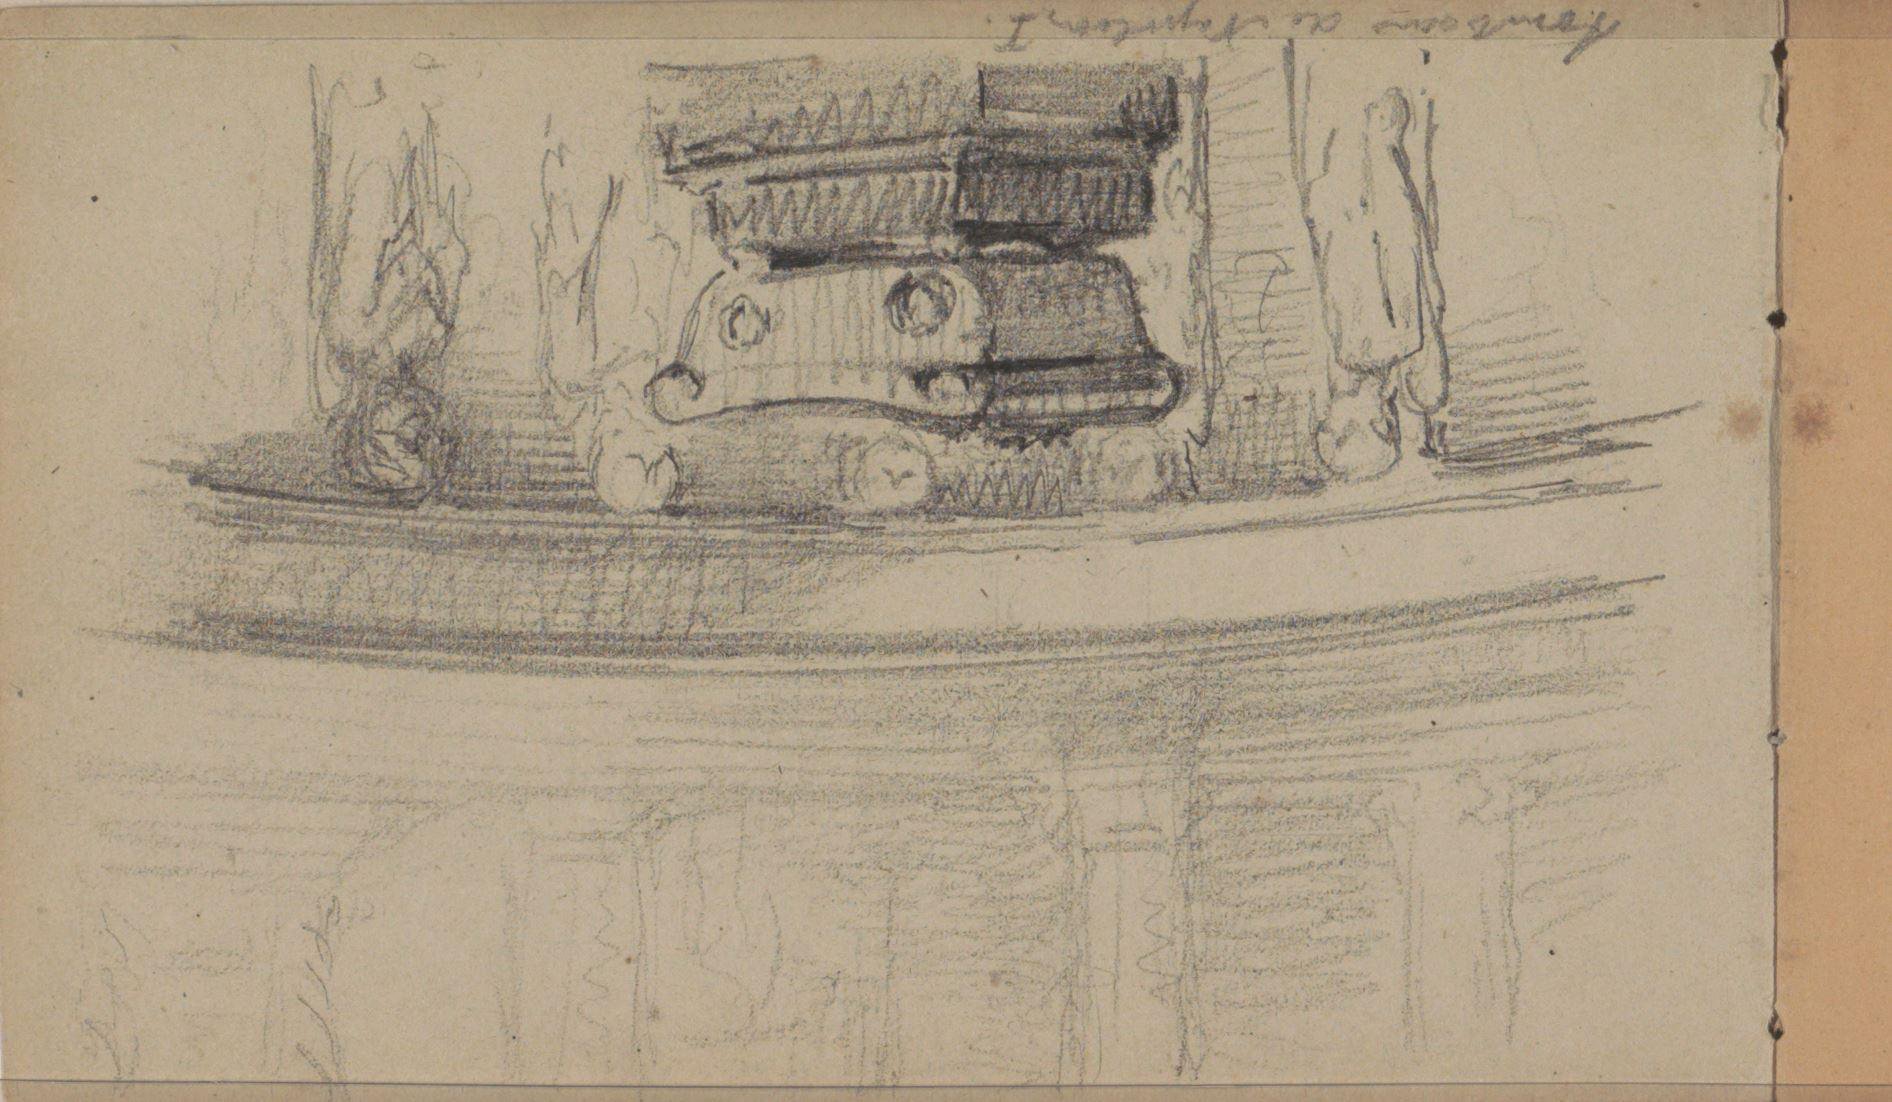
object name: sketchbook leaf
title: Tombe van Napoleon I Bonaparte in de Dôme des Invalides te Parijs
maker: maria vos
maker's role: draughtsman, painter, print maker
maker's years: 1824-1906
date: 1811-1867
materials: paper, pencil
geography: paris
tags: napoleon i (emperor of the french), grave, tomb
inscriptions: annotation: ‘tombeau de Napoleon I’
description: Blad 29 verso uit een schetsboek met 40 bladen.